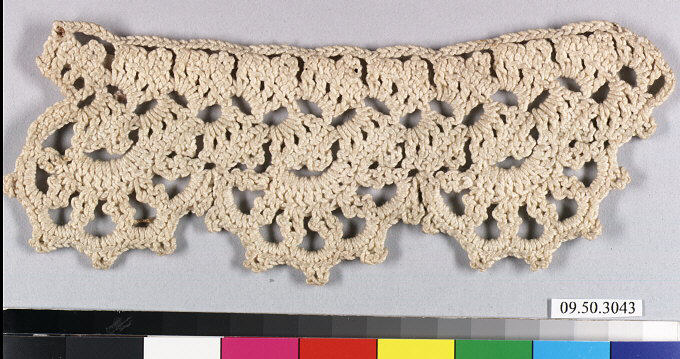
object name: sample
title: Crochet Work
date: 1801-1900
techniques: crochet